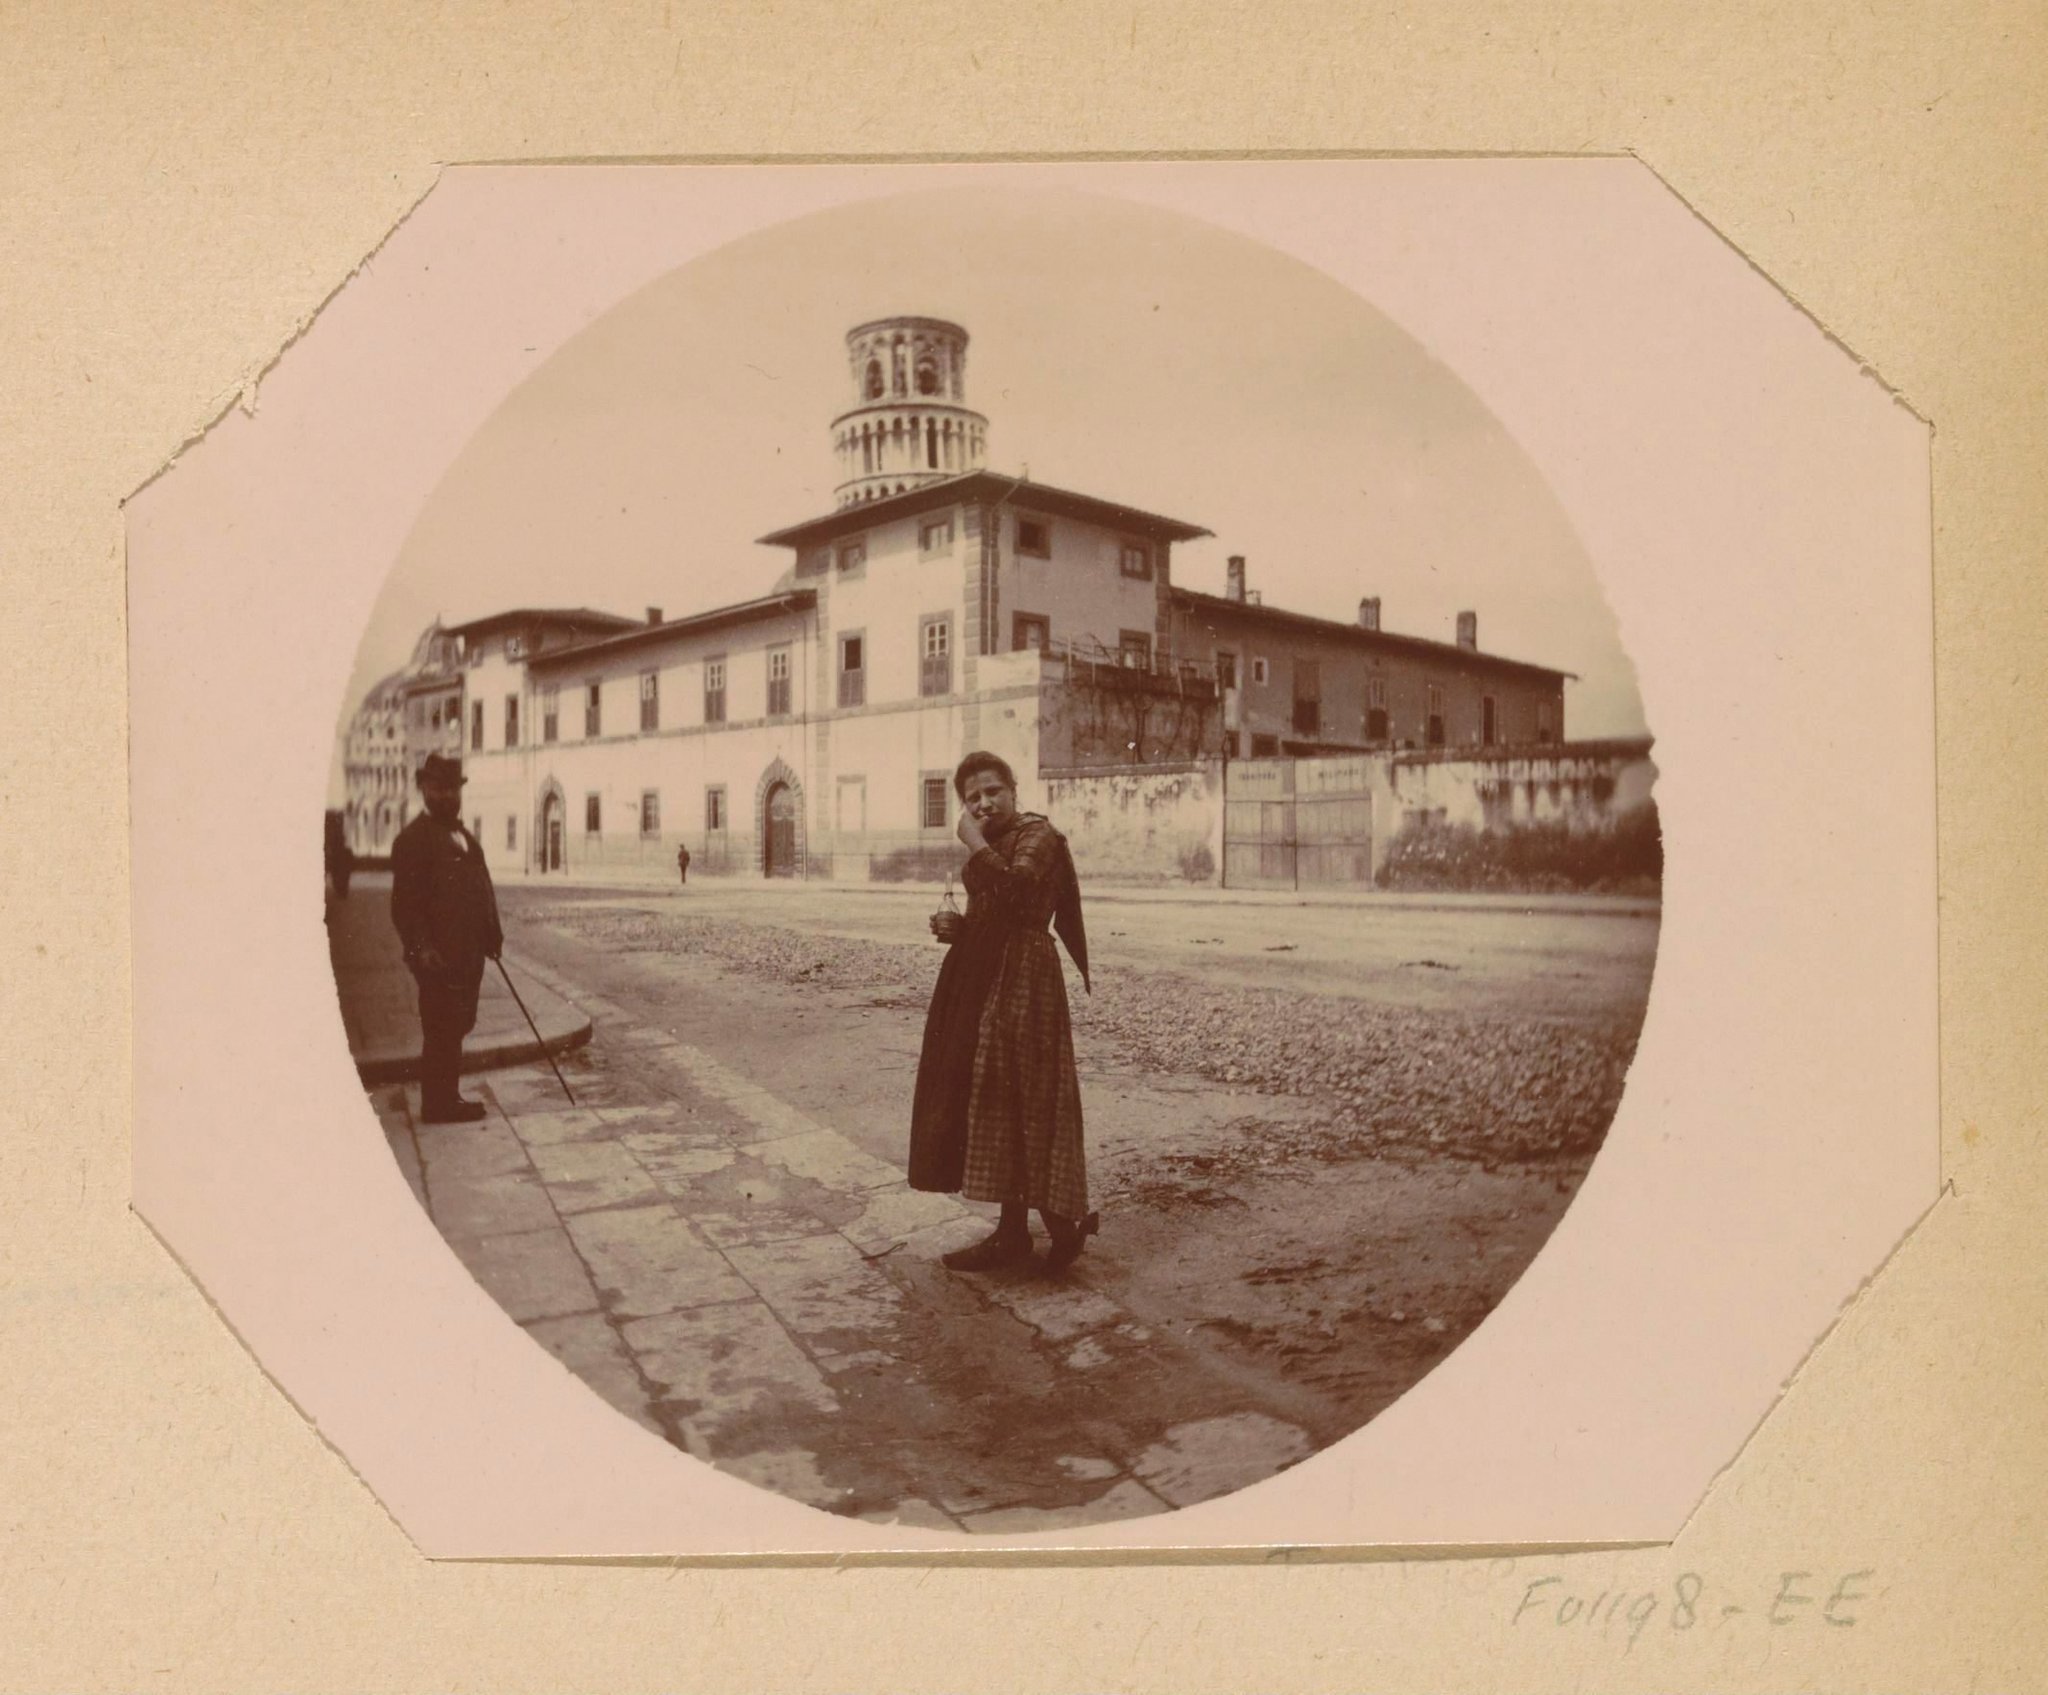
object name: photograph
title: Onbekende vrouw op een straat in Pisa, in de verte de kathedraal en de Toren van Pisa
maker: johanna margaretha piek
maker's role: fotograaf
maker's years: 1870-1947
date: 1889-1893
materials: paper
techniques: gelatin silver print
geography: pisa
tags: adult woman